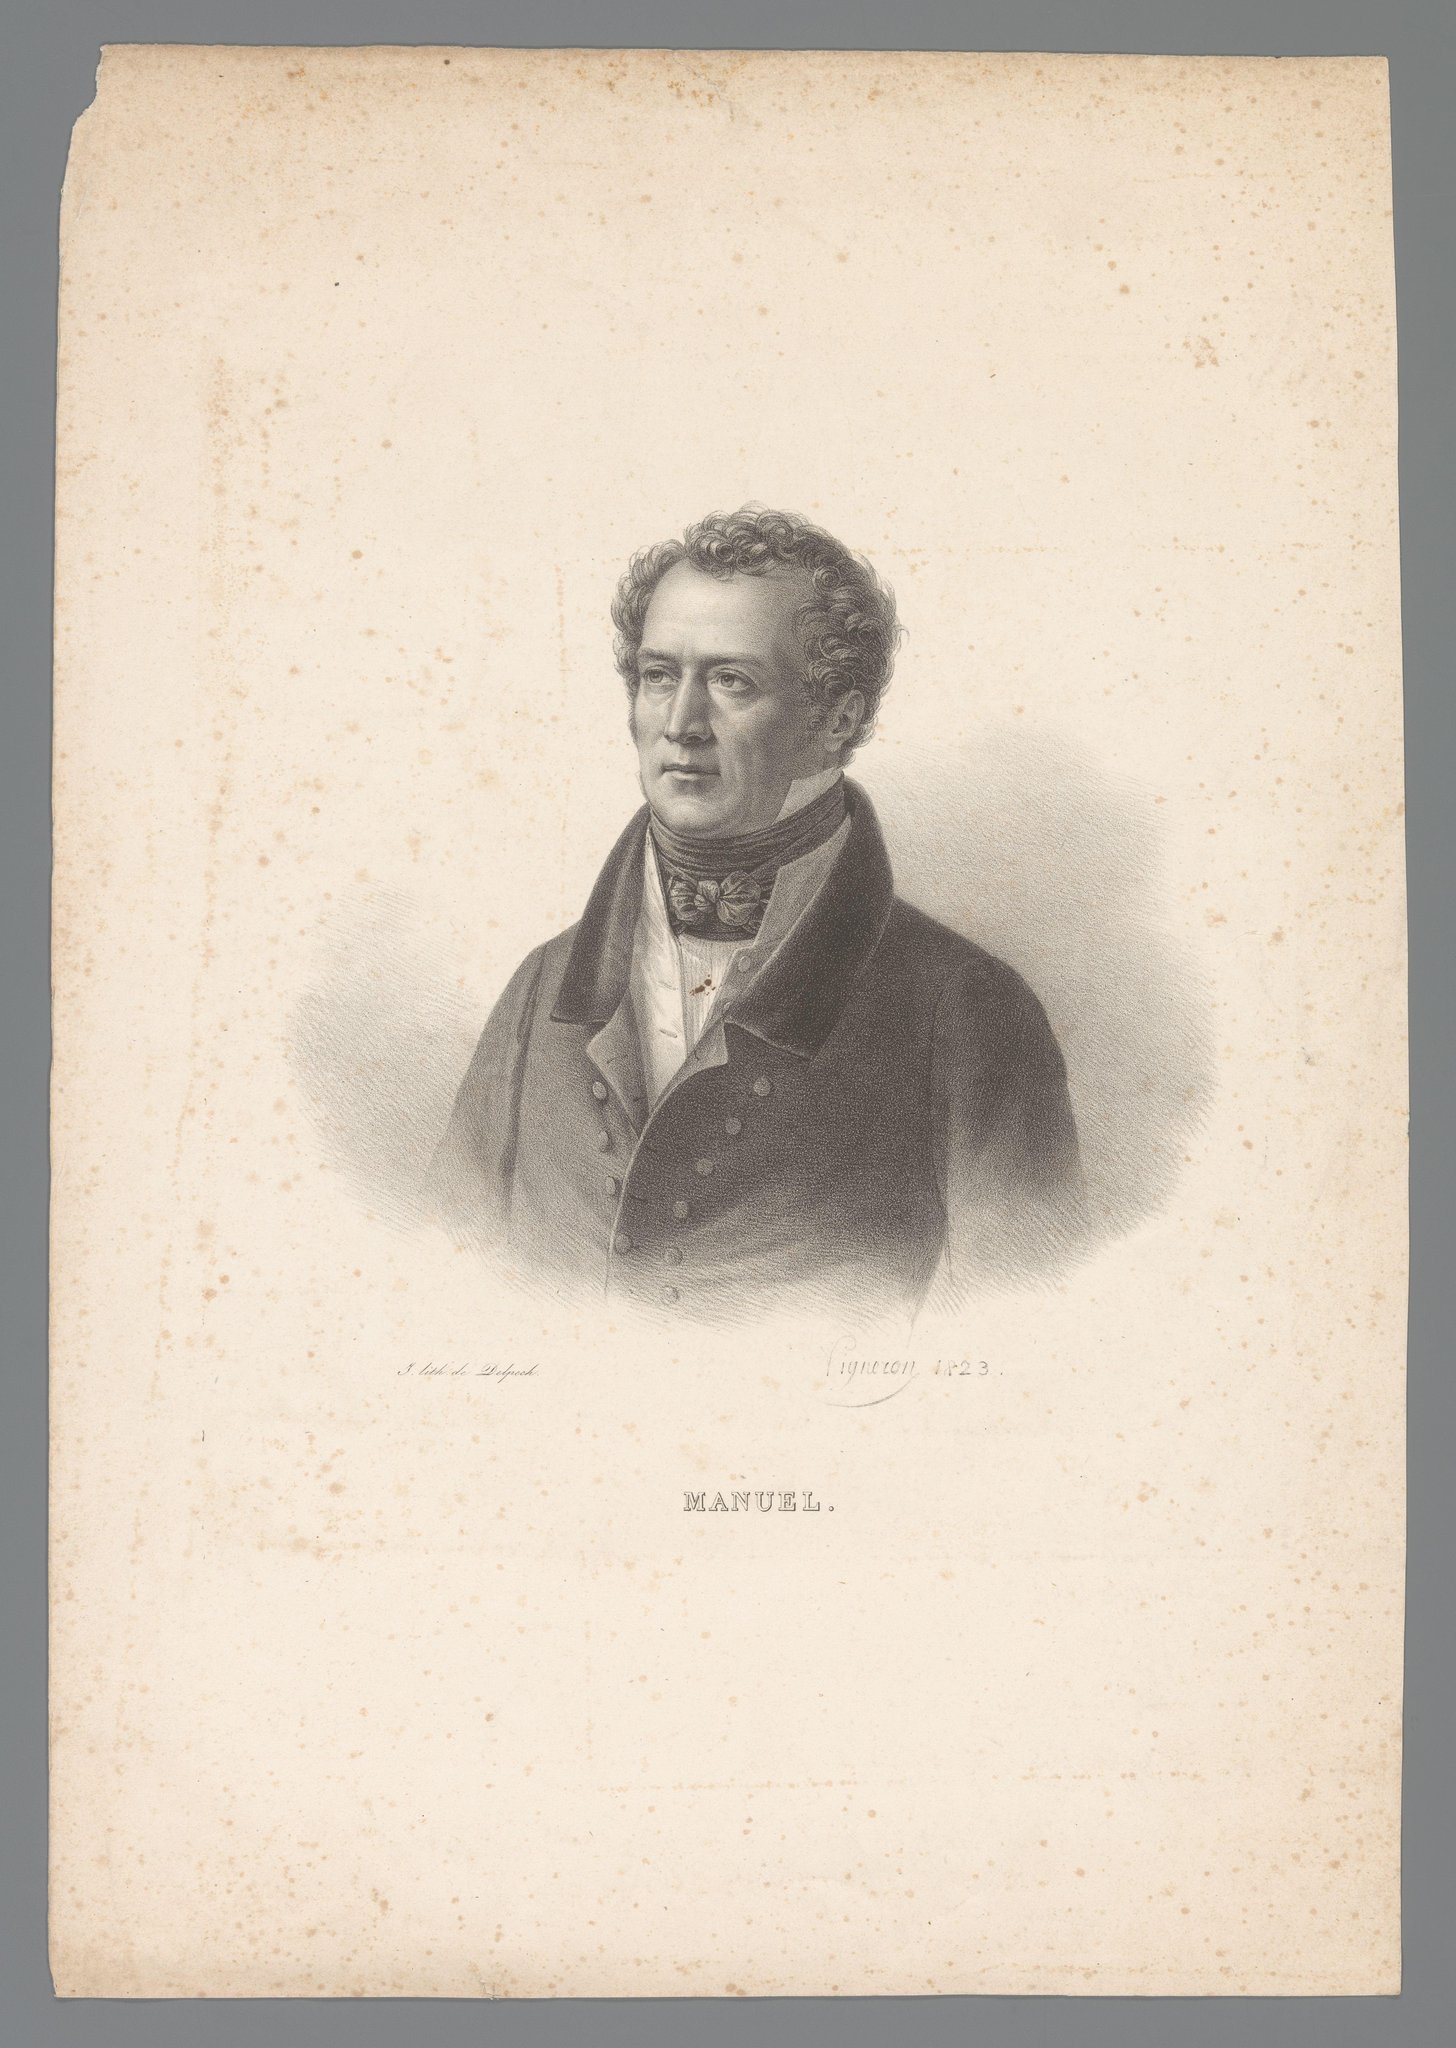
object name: print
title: Manuel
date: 1823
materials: paper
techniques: lithograph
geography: paris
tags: politician, historical persons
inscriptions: collector's mark: Lugt 2228